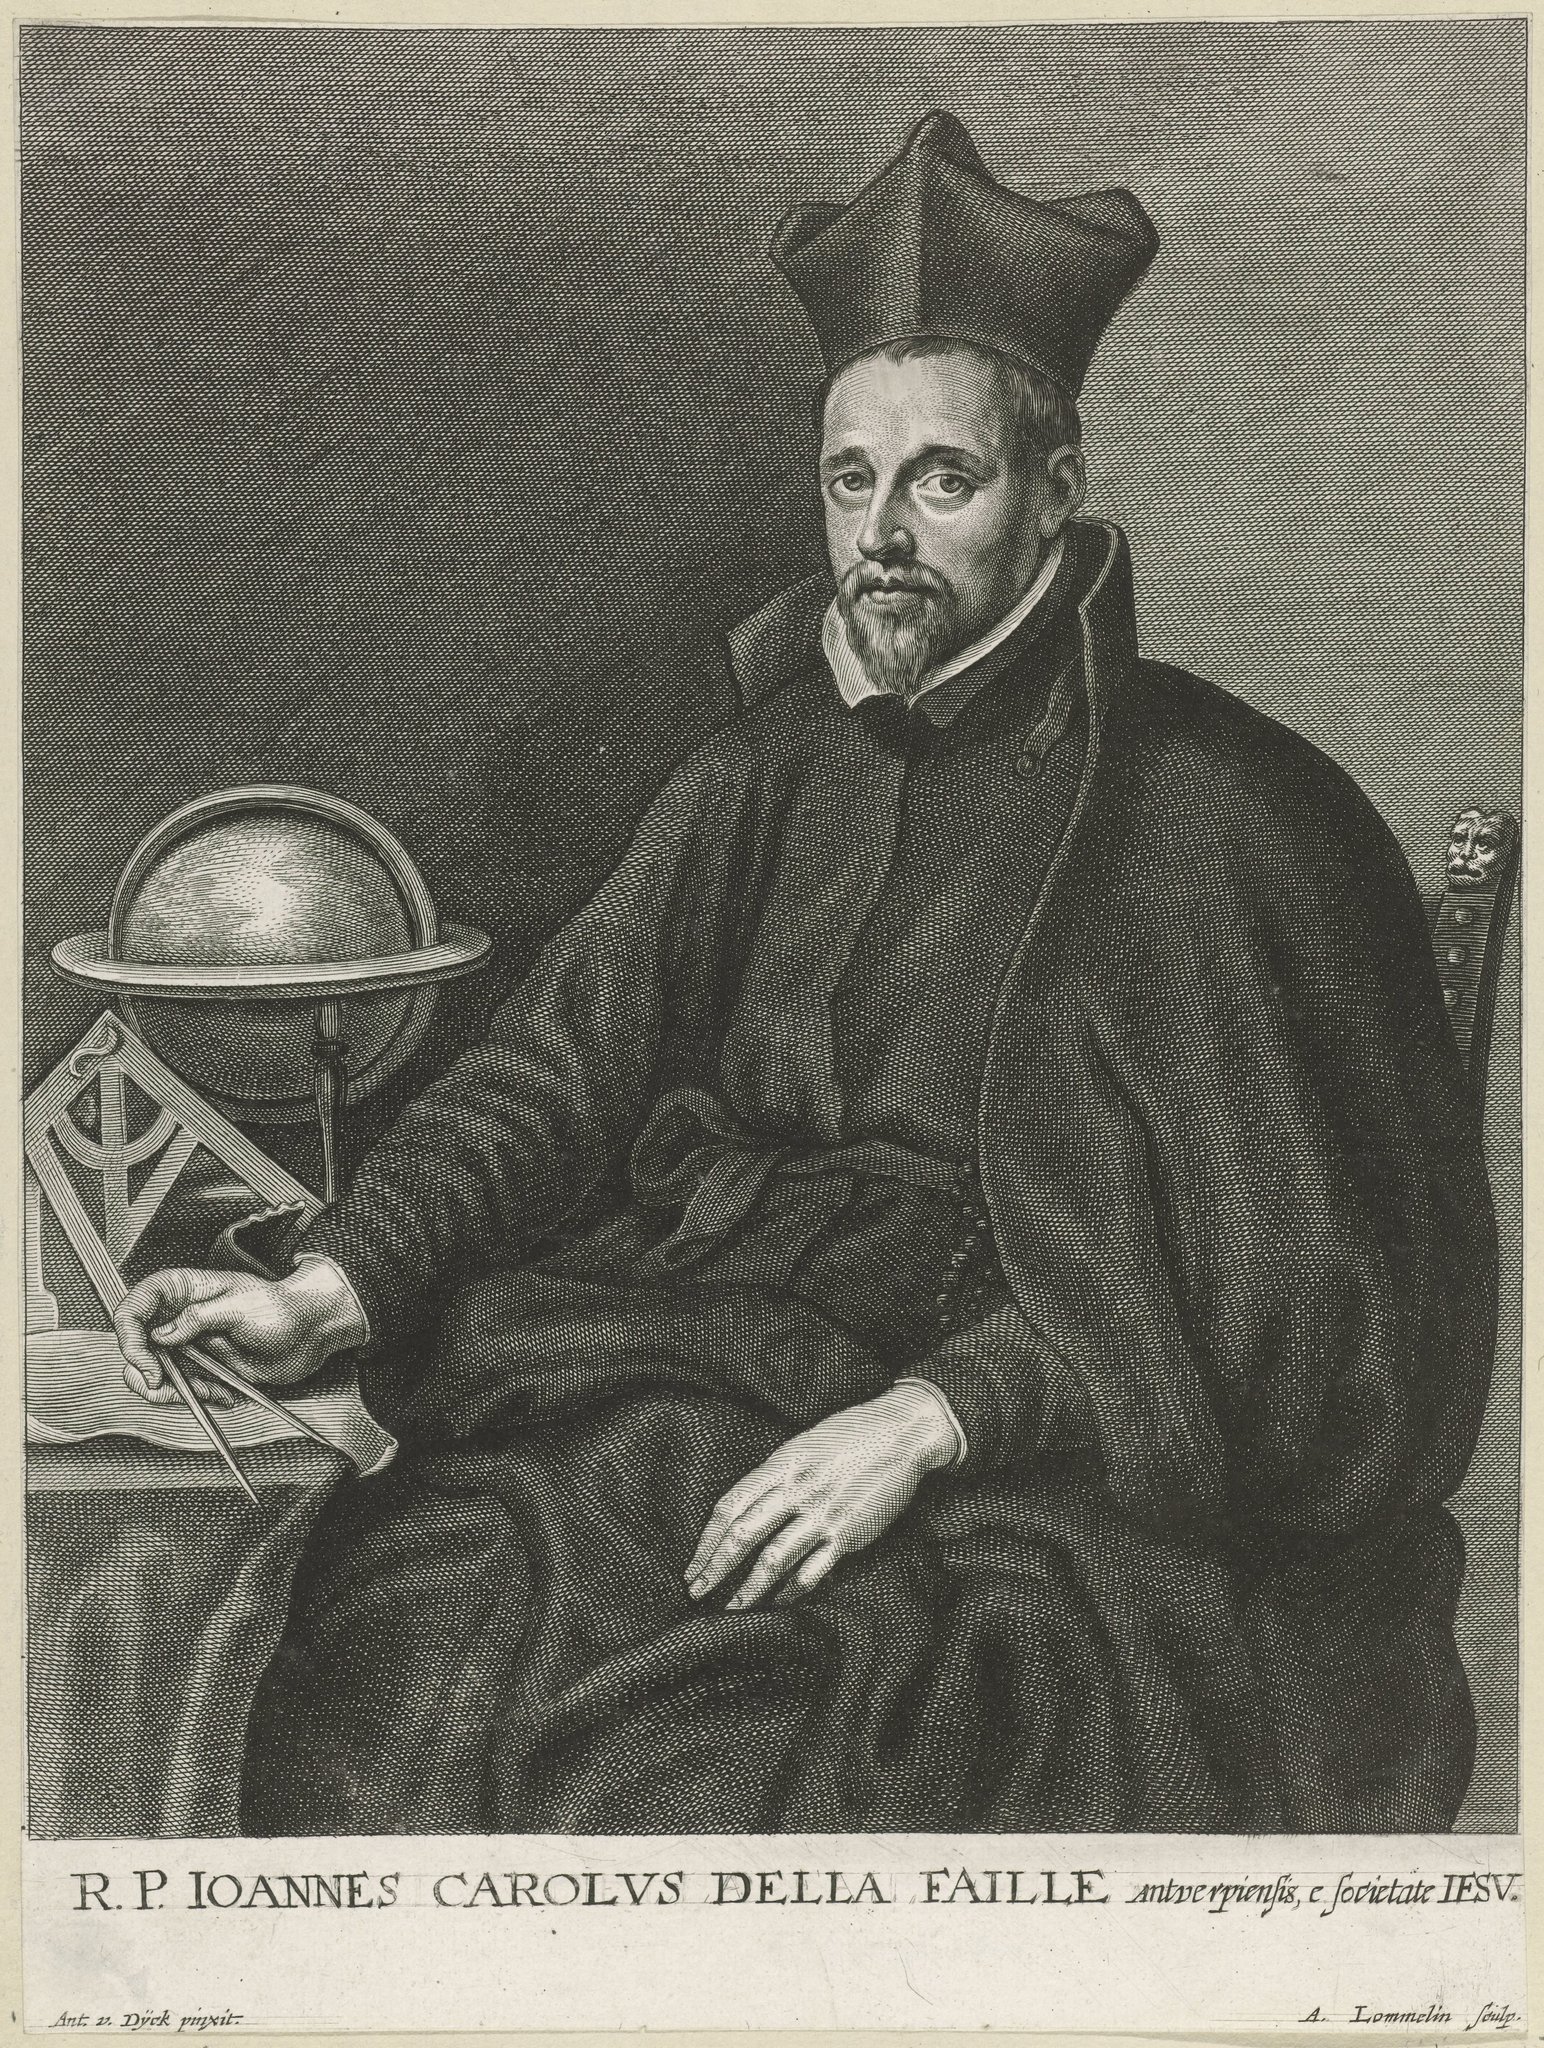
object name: print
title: Portret van Johannes Carolus de la Faille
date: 1630-1677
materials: paper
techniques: engraving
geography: antwerp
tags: jezuïet, johannes carolus de la faille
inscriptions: collector's mark: Lugt 240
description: Portret van Johannes Carolus de la Faille, Jezuïet en wiskundige.